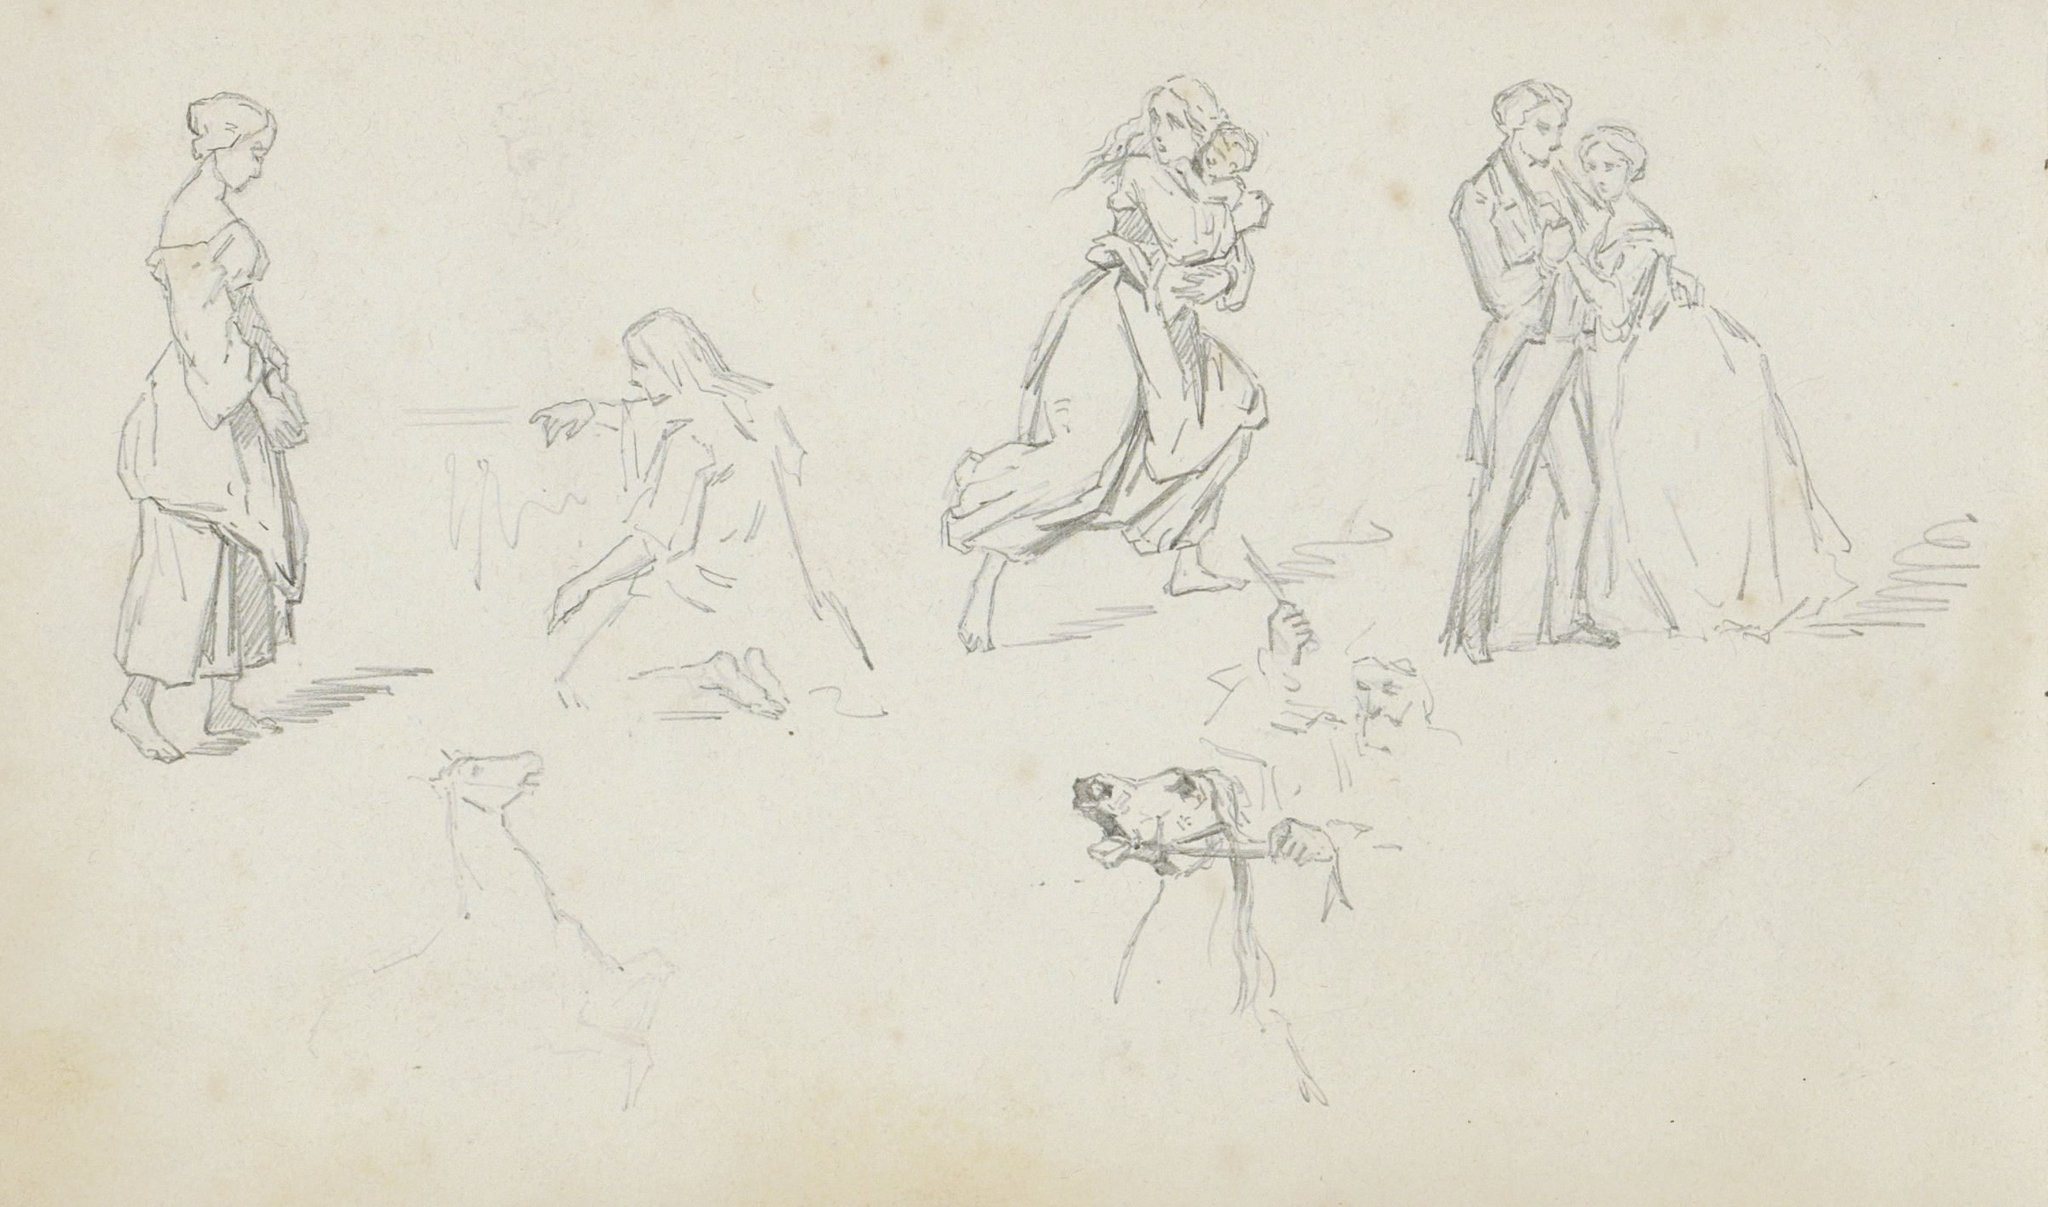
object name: sketchbook leaf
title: Figuurstudies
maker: charles rochussen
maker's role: draughtsman, painter, print maker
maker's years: 1814-1894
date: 1840-1860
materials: paper, pencil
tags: riding a horse, ass, or mule; rider, horseman, mother and baby or young child, couple of lovers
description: Onder andere studies van een liefdespaar, een vrouw met kind en een ruiter met een mes. Blad 19 verso uit een schetsboek met 38 bladen.